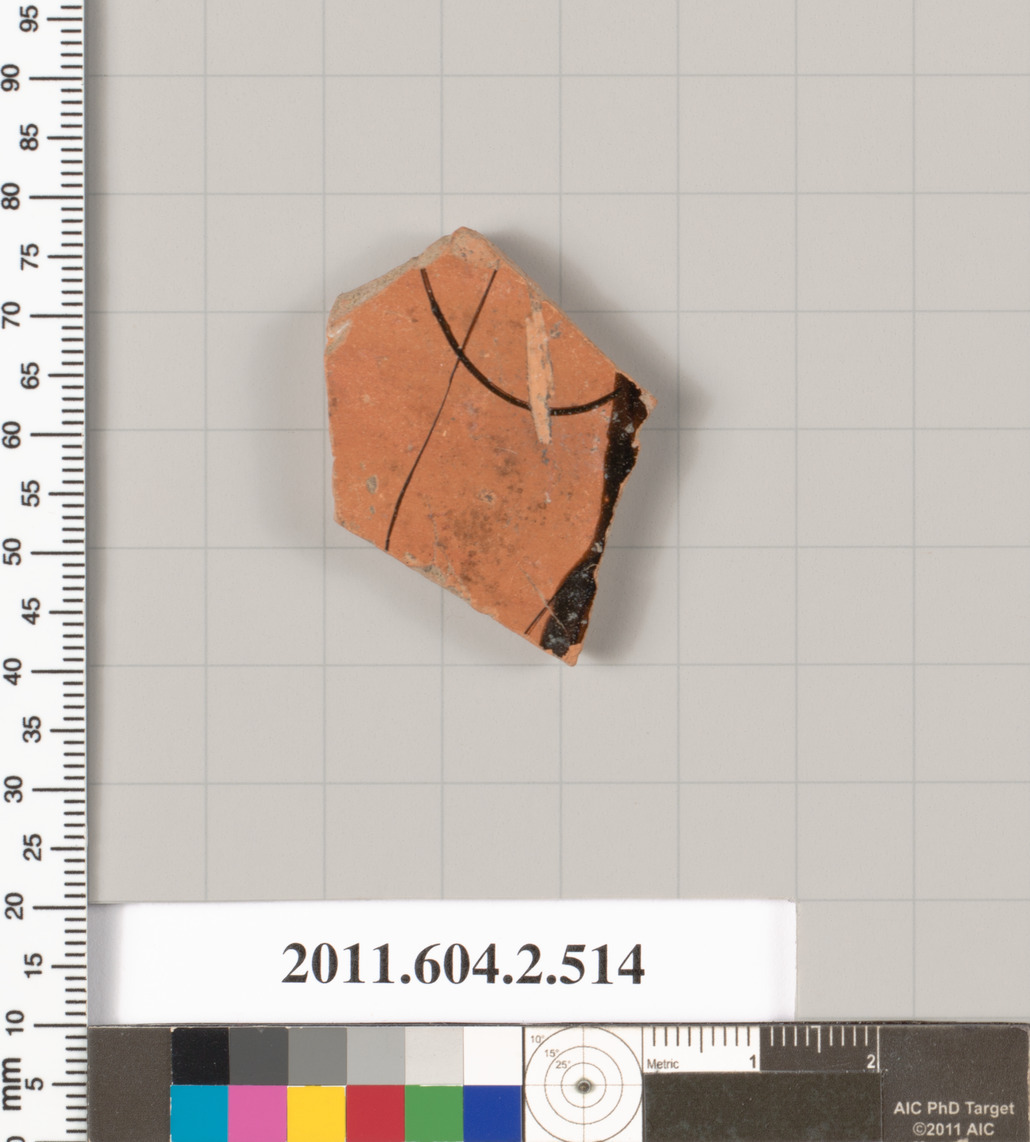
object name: column krater fragment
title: Terracotta fragment of a column-krater (bowl for mixing wine and water)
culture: greek, attic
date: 460-440 BCE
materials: terracotta